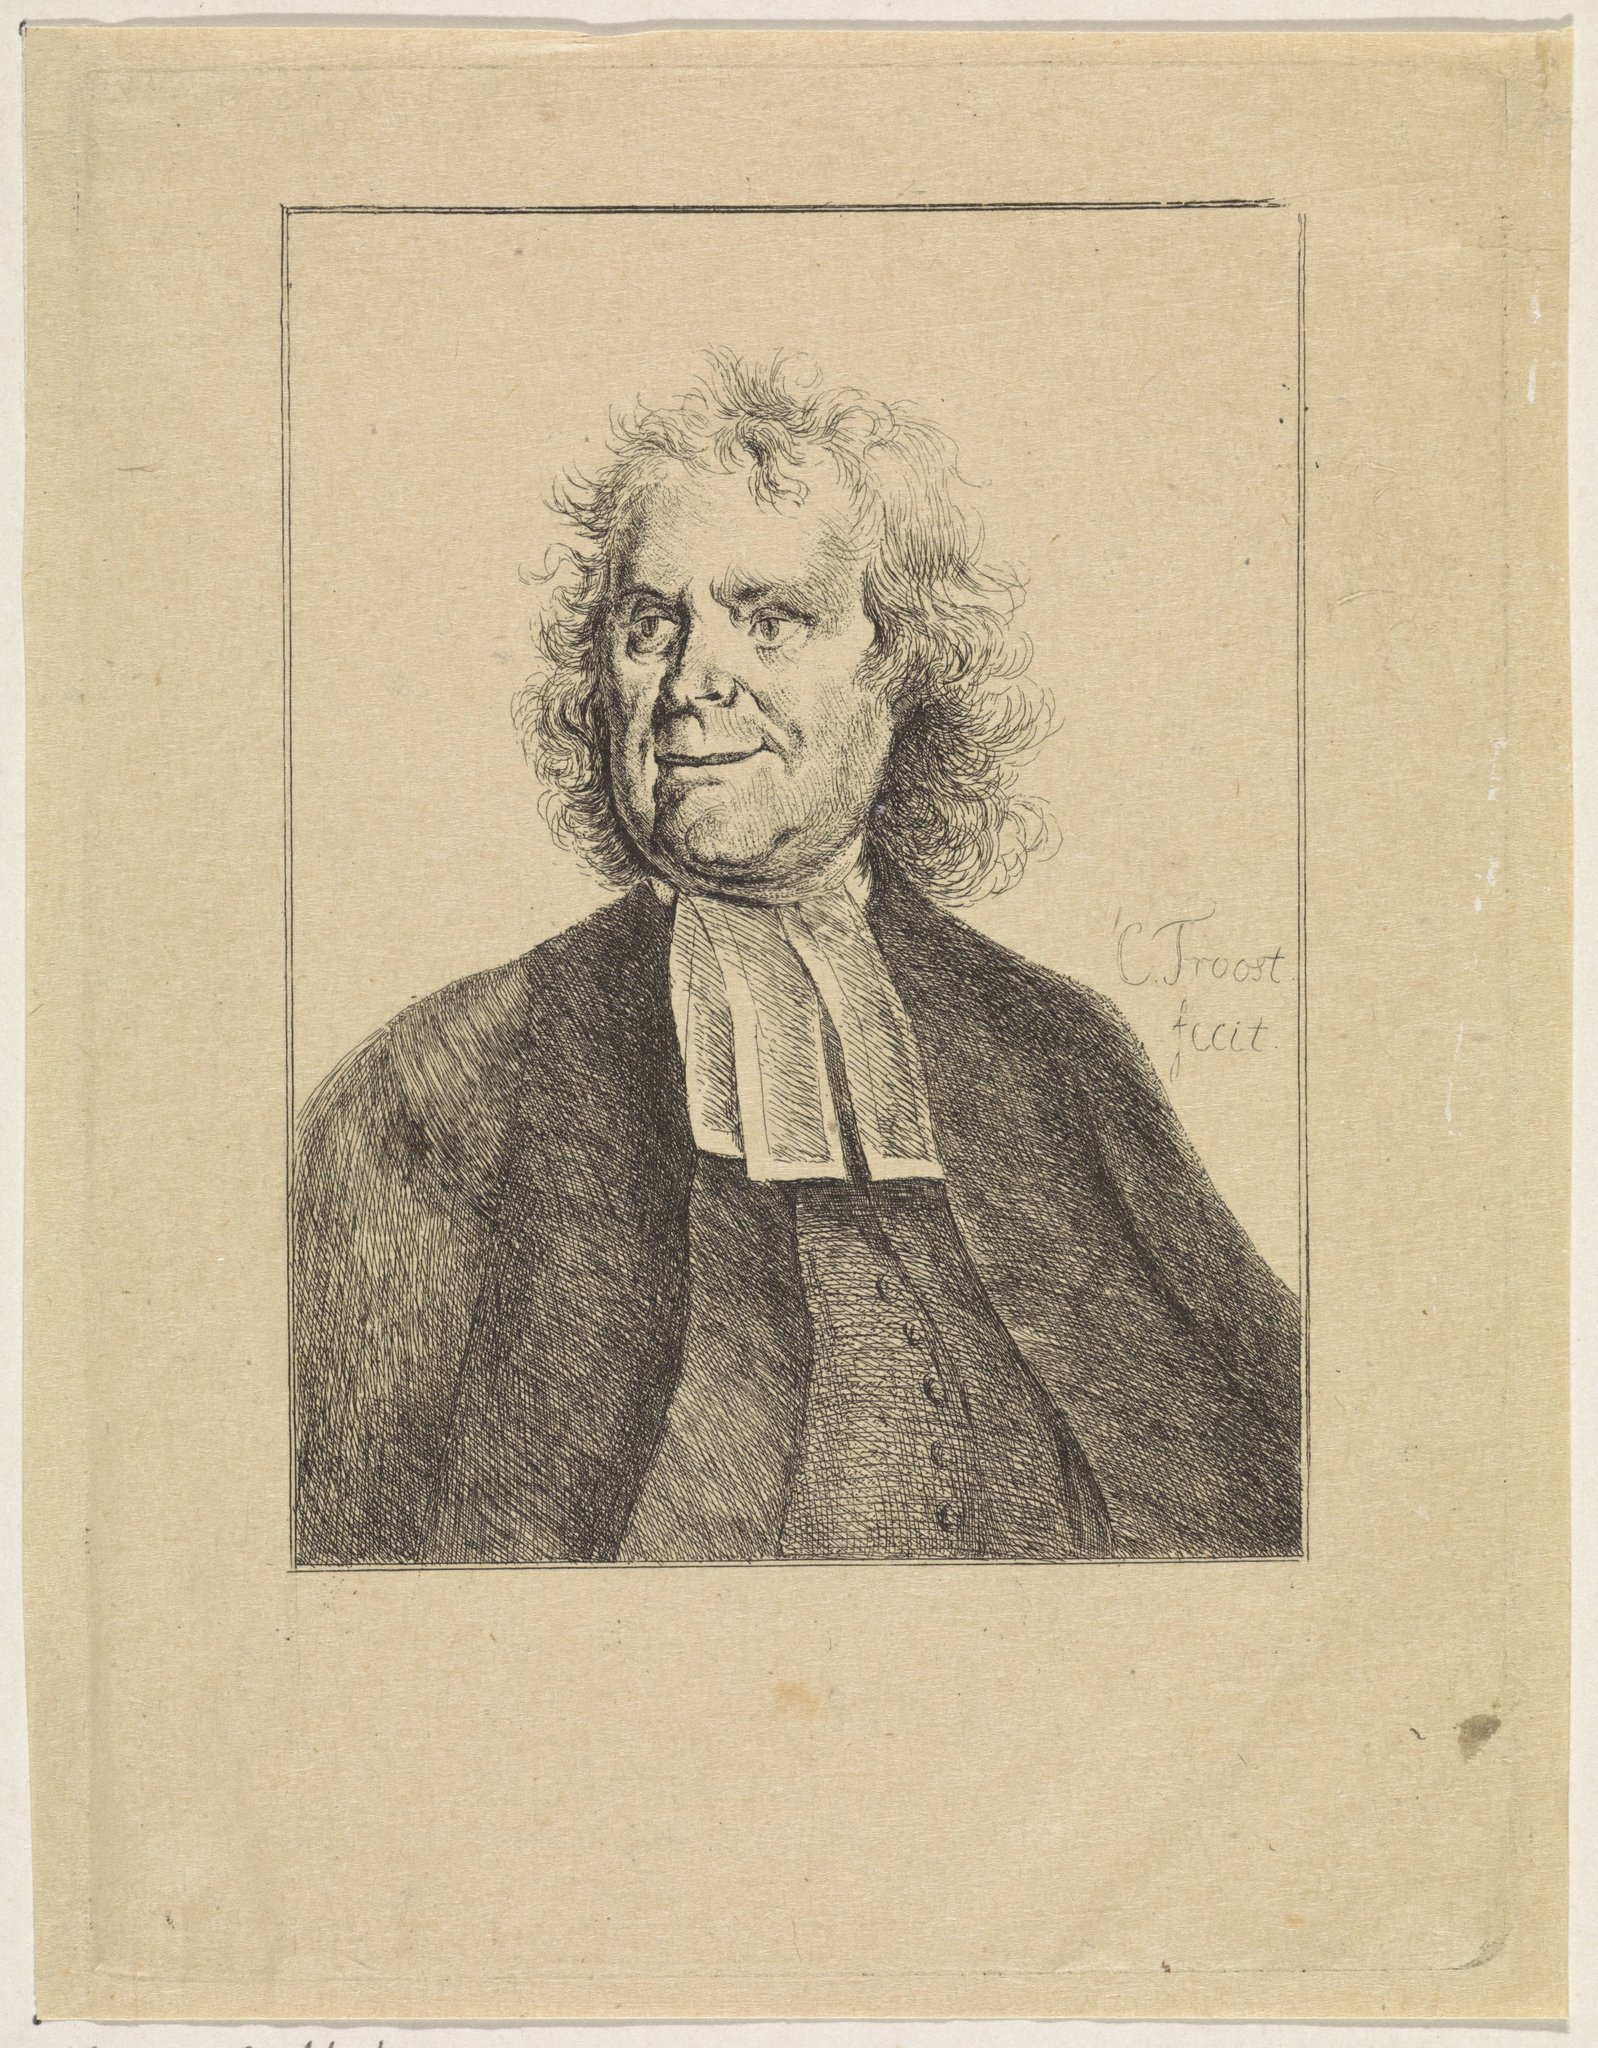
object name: print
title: Portret van Hermanus Boerhaave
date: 1762-1782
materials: paper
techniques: etching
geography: the hague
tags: leiden, hermanus boerhaave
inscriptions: collector's mark: Lugt 240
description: Portret van Hermanus Boerhaave, hoogleraar in de geneeskunde en botanie.